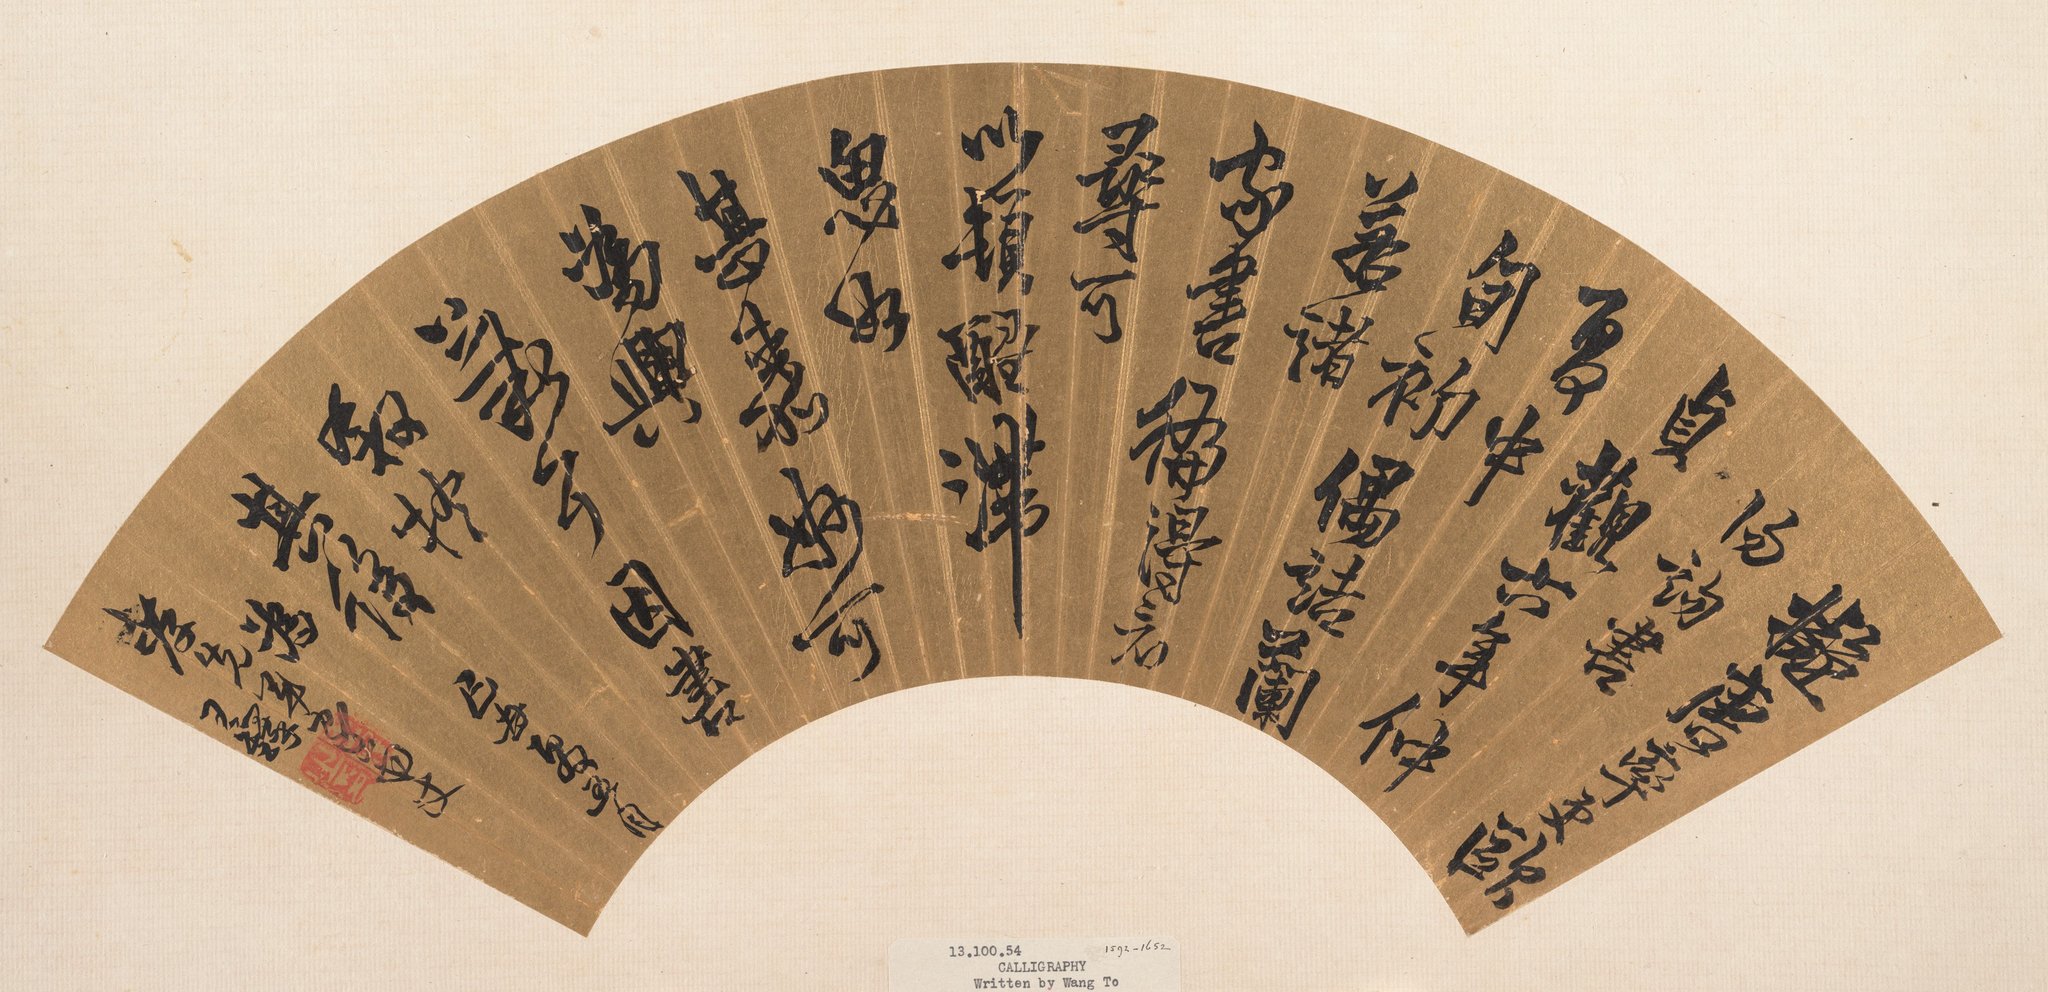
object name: folding fan mounted a an album leaf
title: Calligraphy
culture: chinese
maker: unidentified artist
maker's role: artist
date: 1601-1700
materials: ink, paper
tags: calligraphy